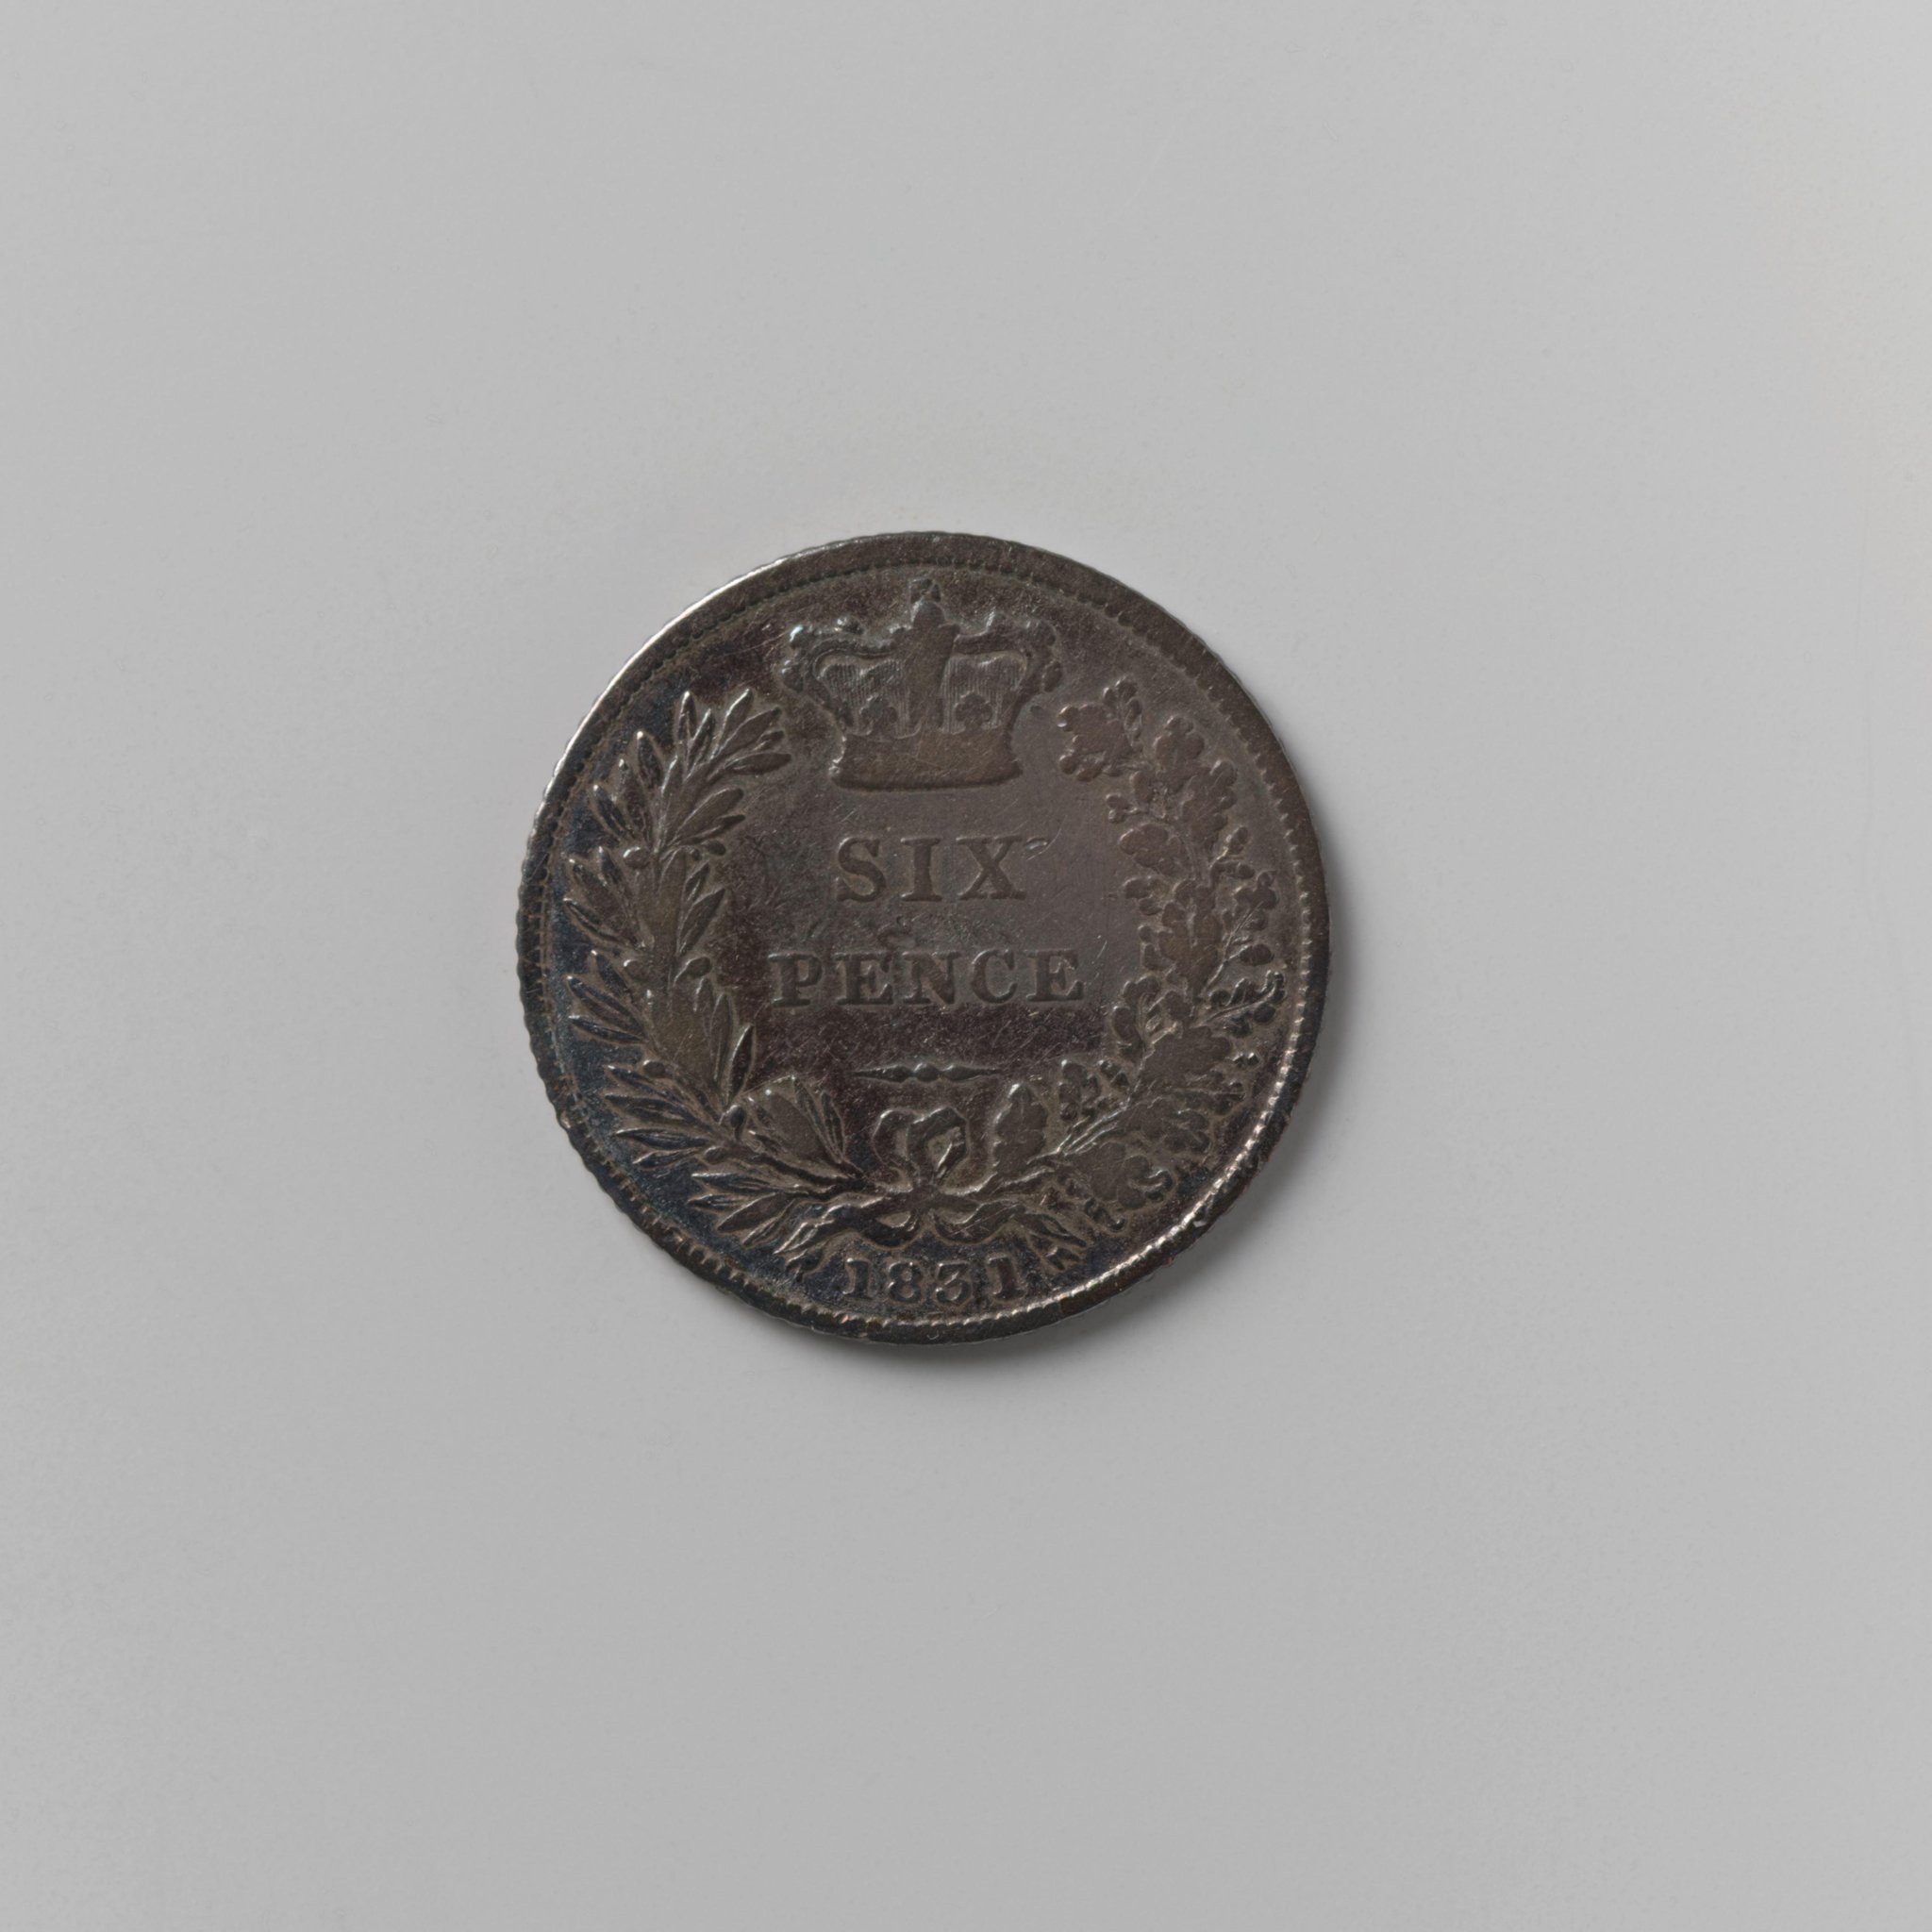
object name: coin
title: 6 pence uit Engeland van William IV, 1831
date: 1831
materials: silver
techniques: striking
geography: london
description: Zilveren munt. Voorzijde: hoofd van de koning naar rechts. Keerzijde: binnen samengebonden laurier- en eikentak in twee regels waarde-aanduiding, waarboven kroon. Jaartal onderaan. Kartelrand.